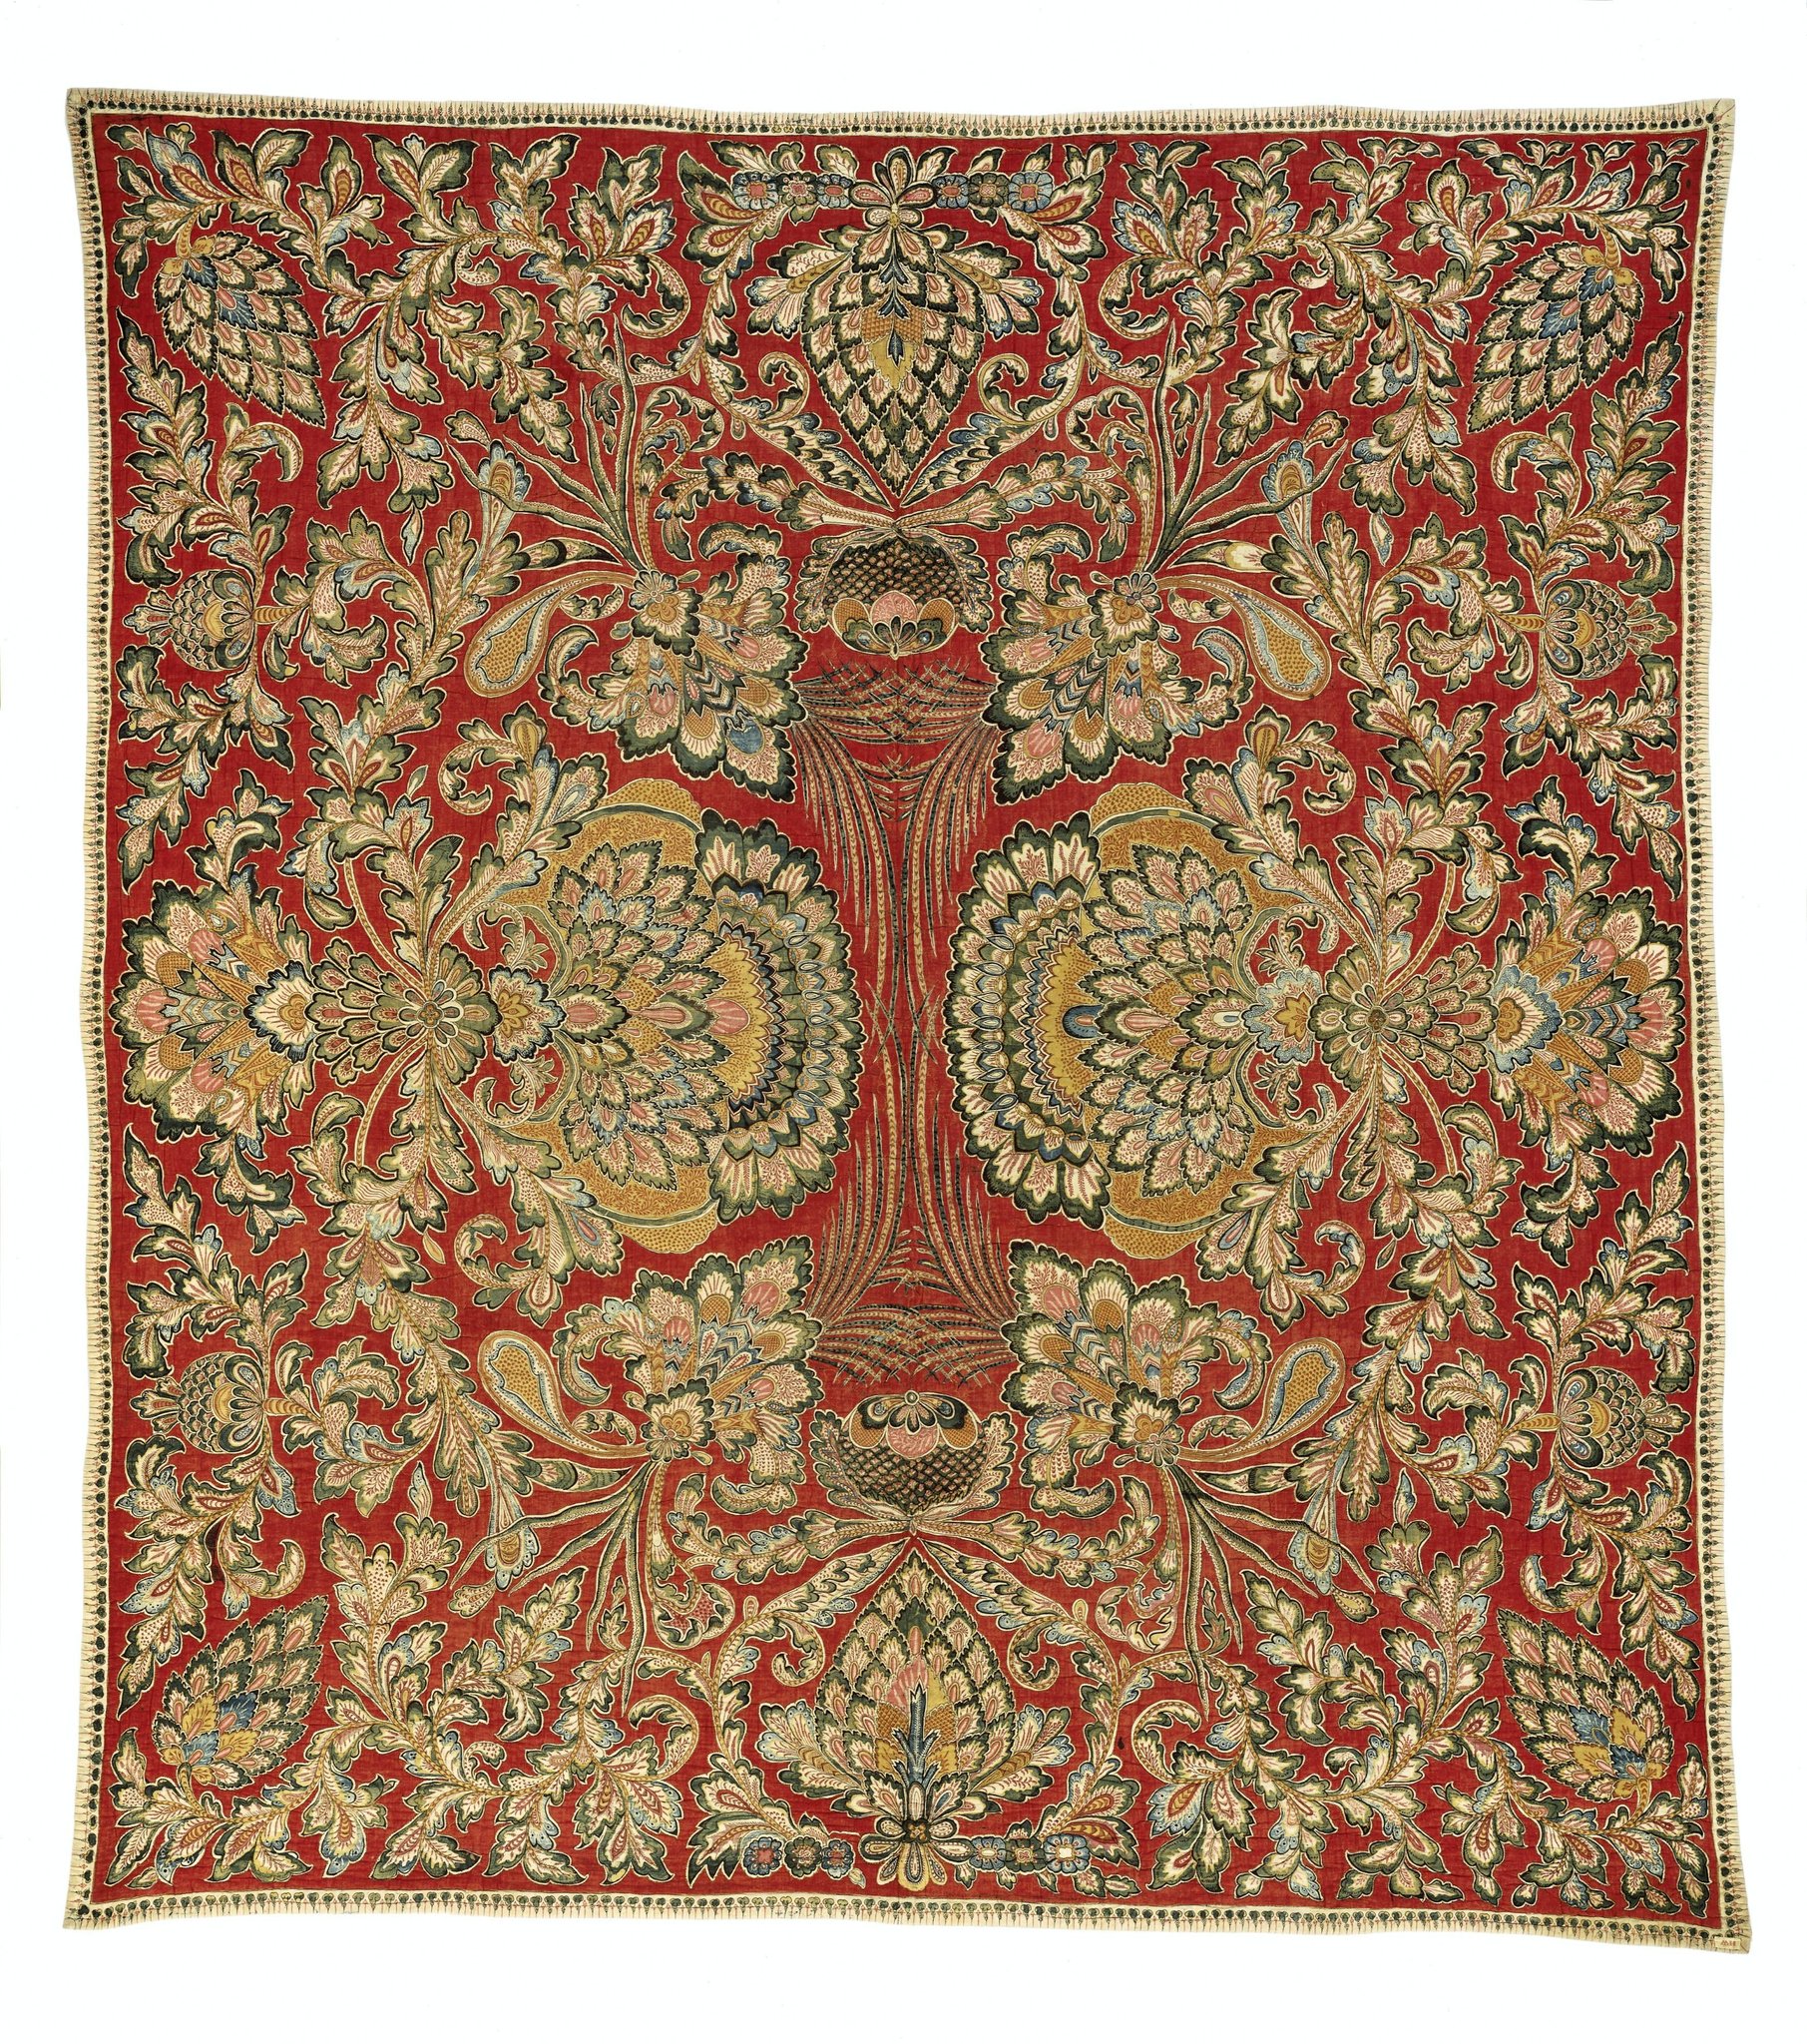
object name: bedspread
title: Deken met grote bebladerde takken met palmetten, bloemen, en vruchten.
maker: Anonymous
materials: textile, silk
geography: coromandel coast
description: Doorgestikt sitsen sprei, versierd met grote bebladerde takken met palmetten, bloemen en vruchten. Geelzijden voering.